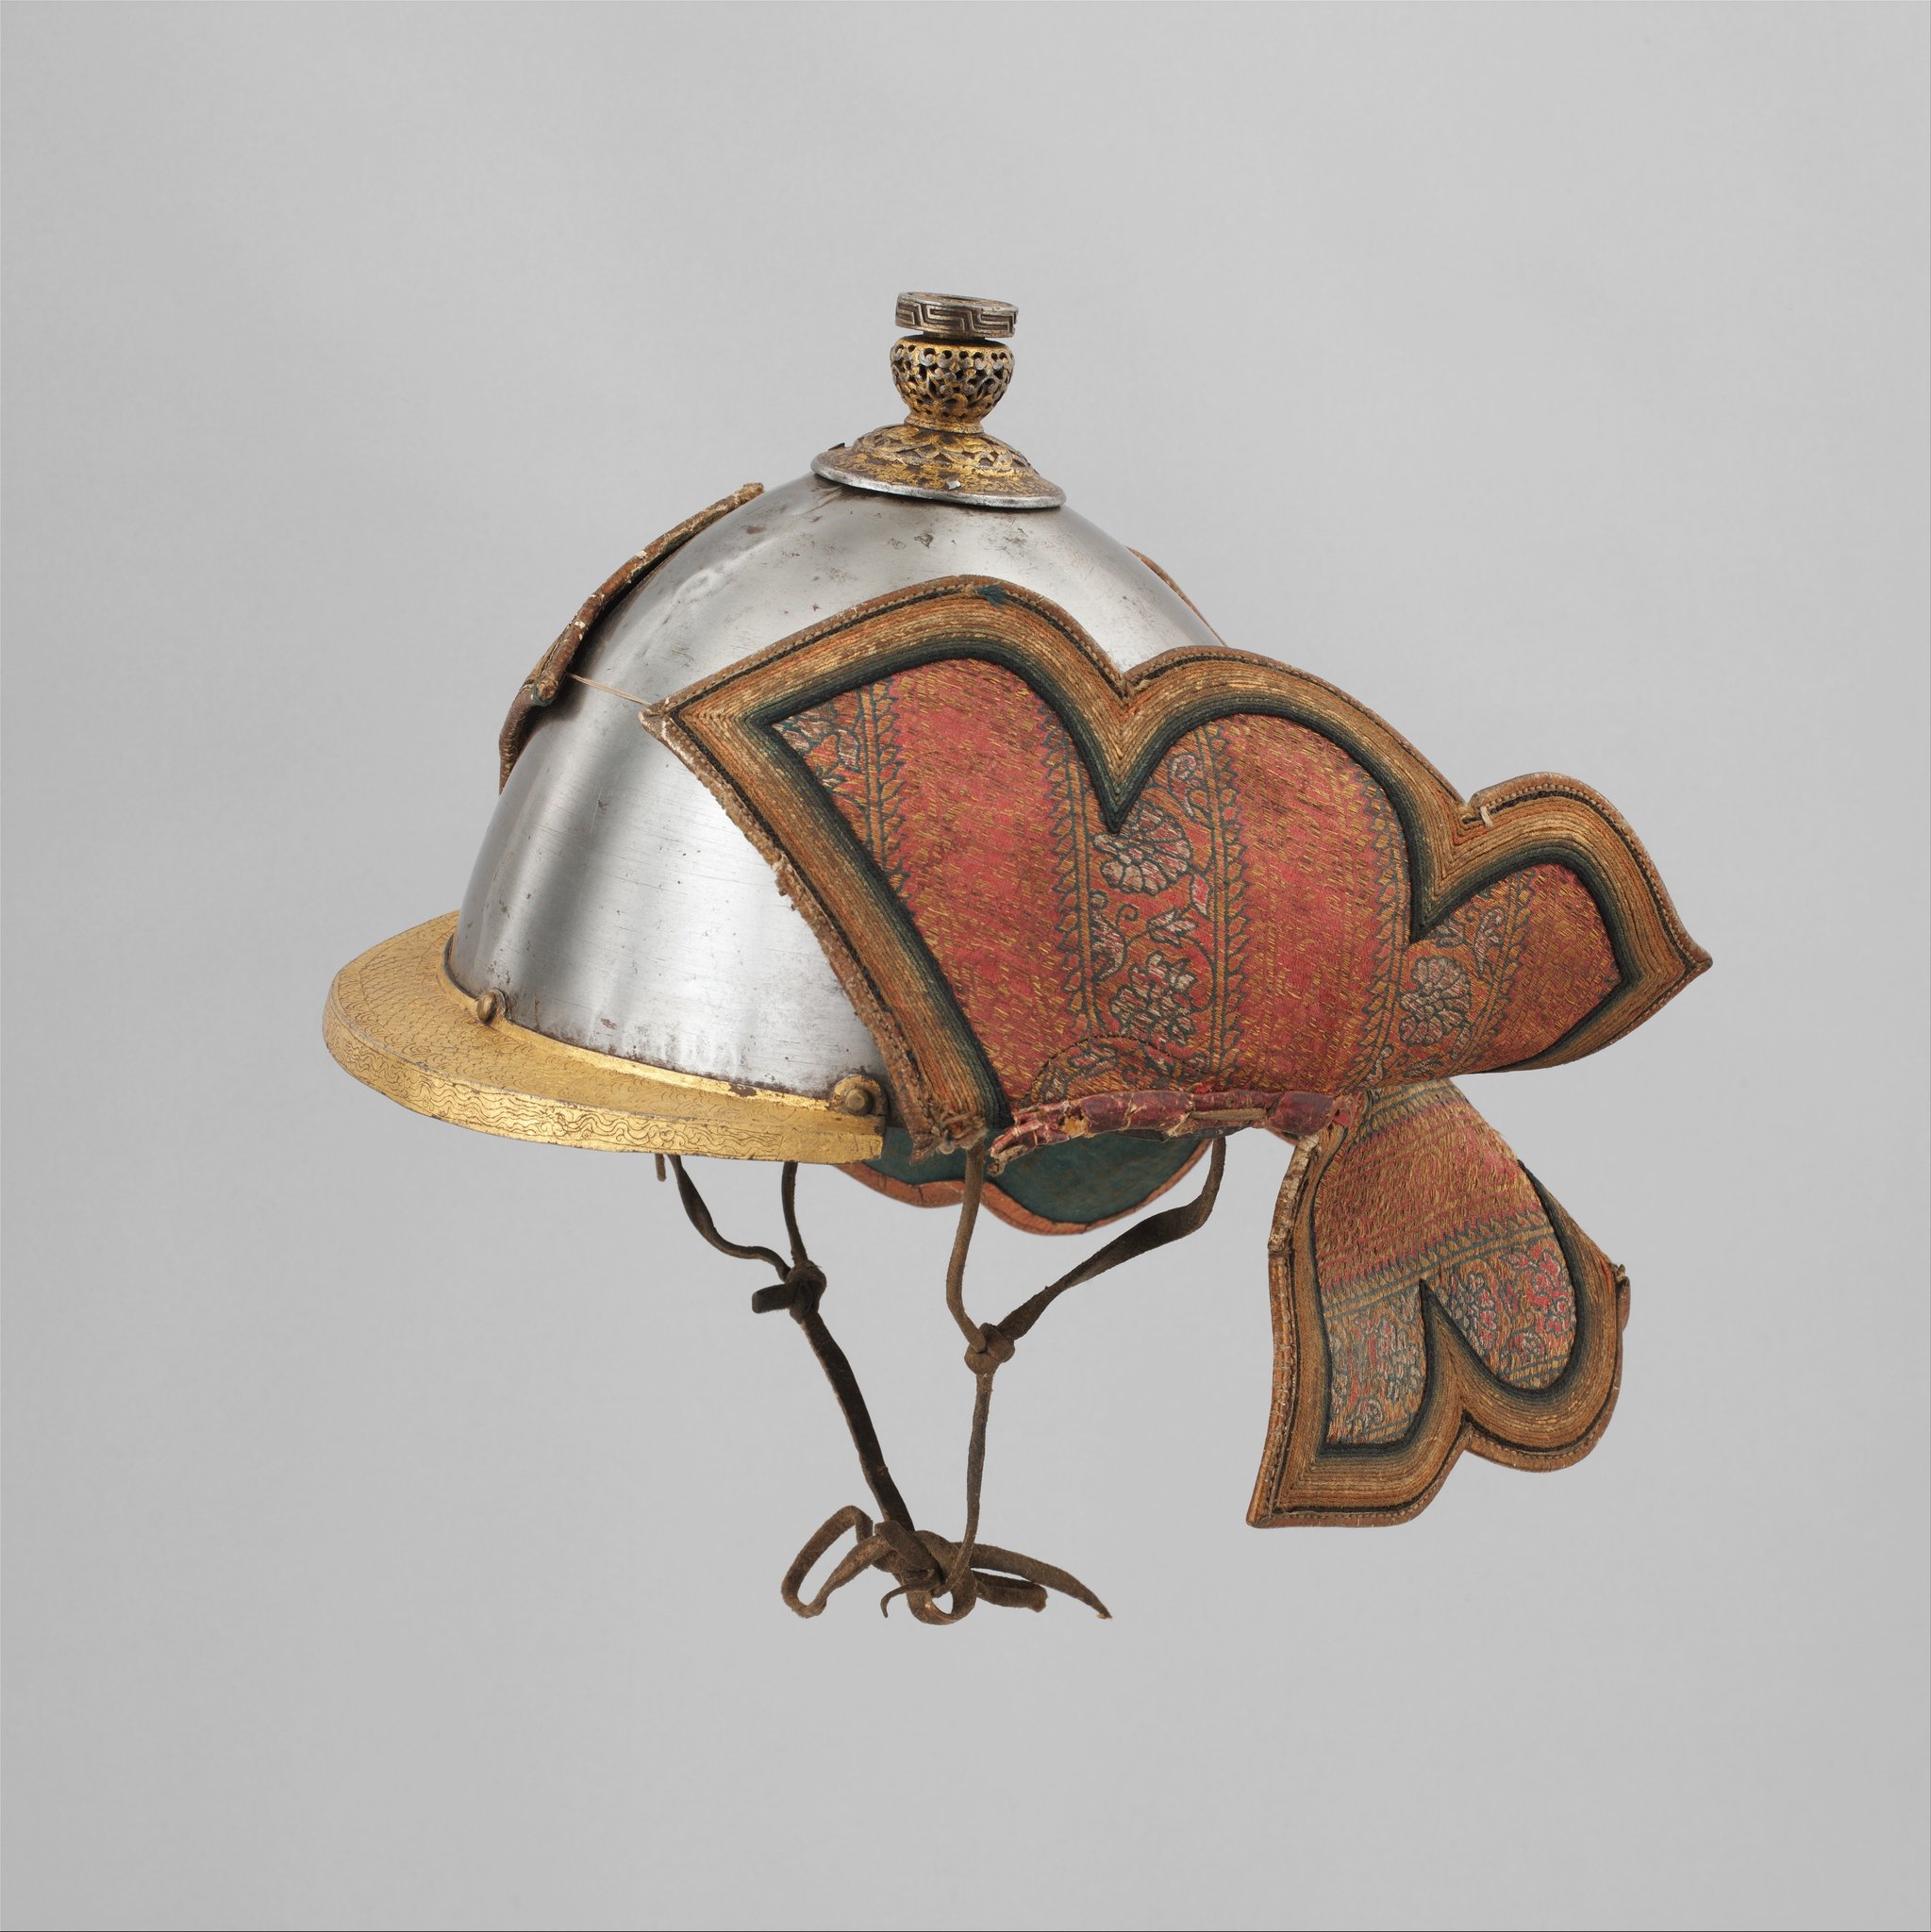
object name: helmet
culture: bhutanese or tibetan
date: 1701-1900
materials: gold, iron, metal thread, silk, steel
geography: tibet